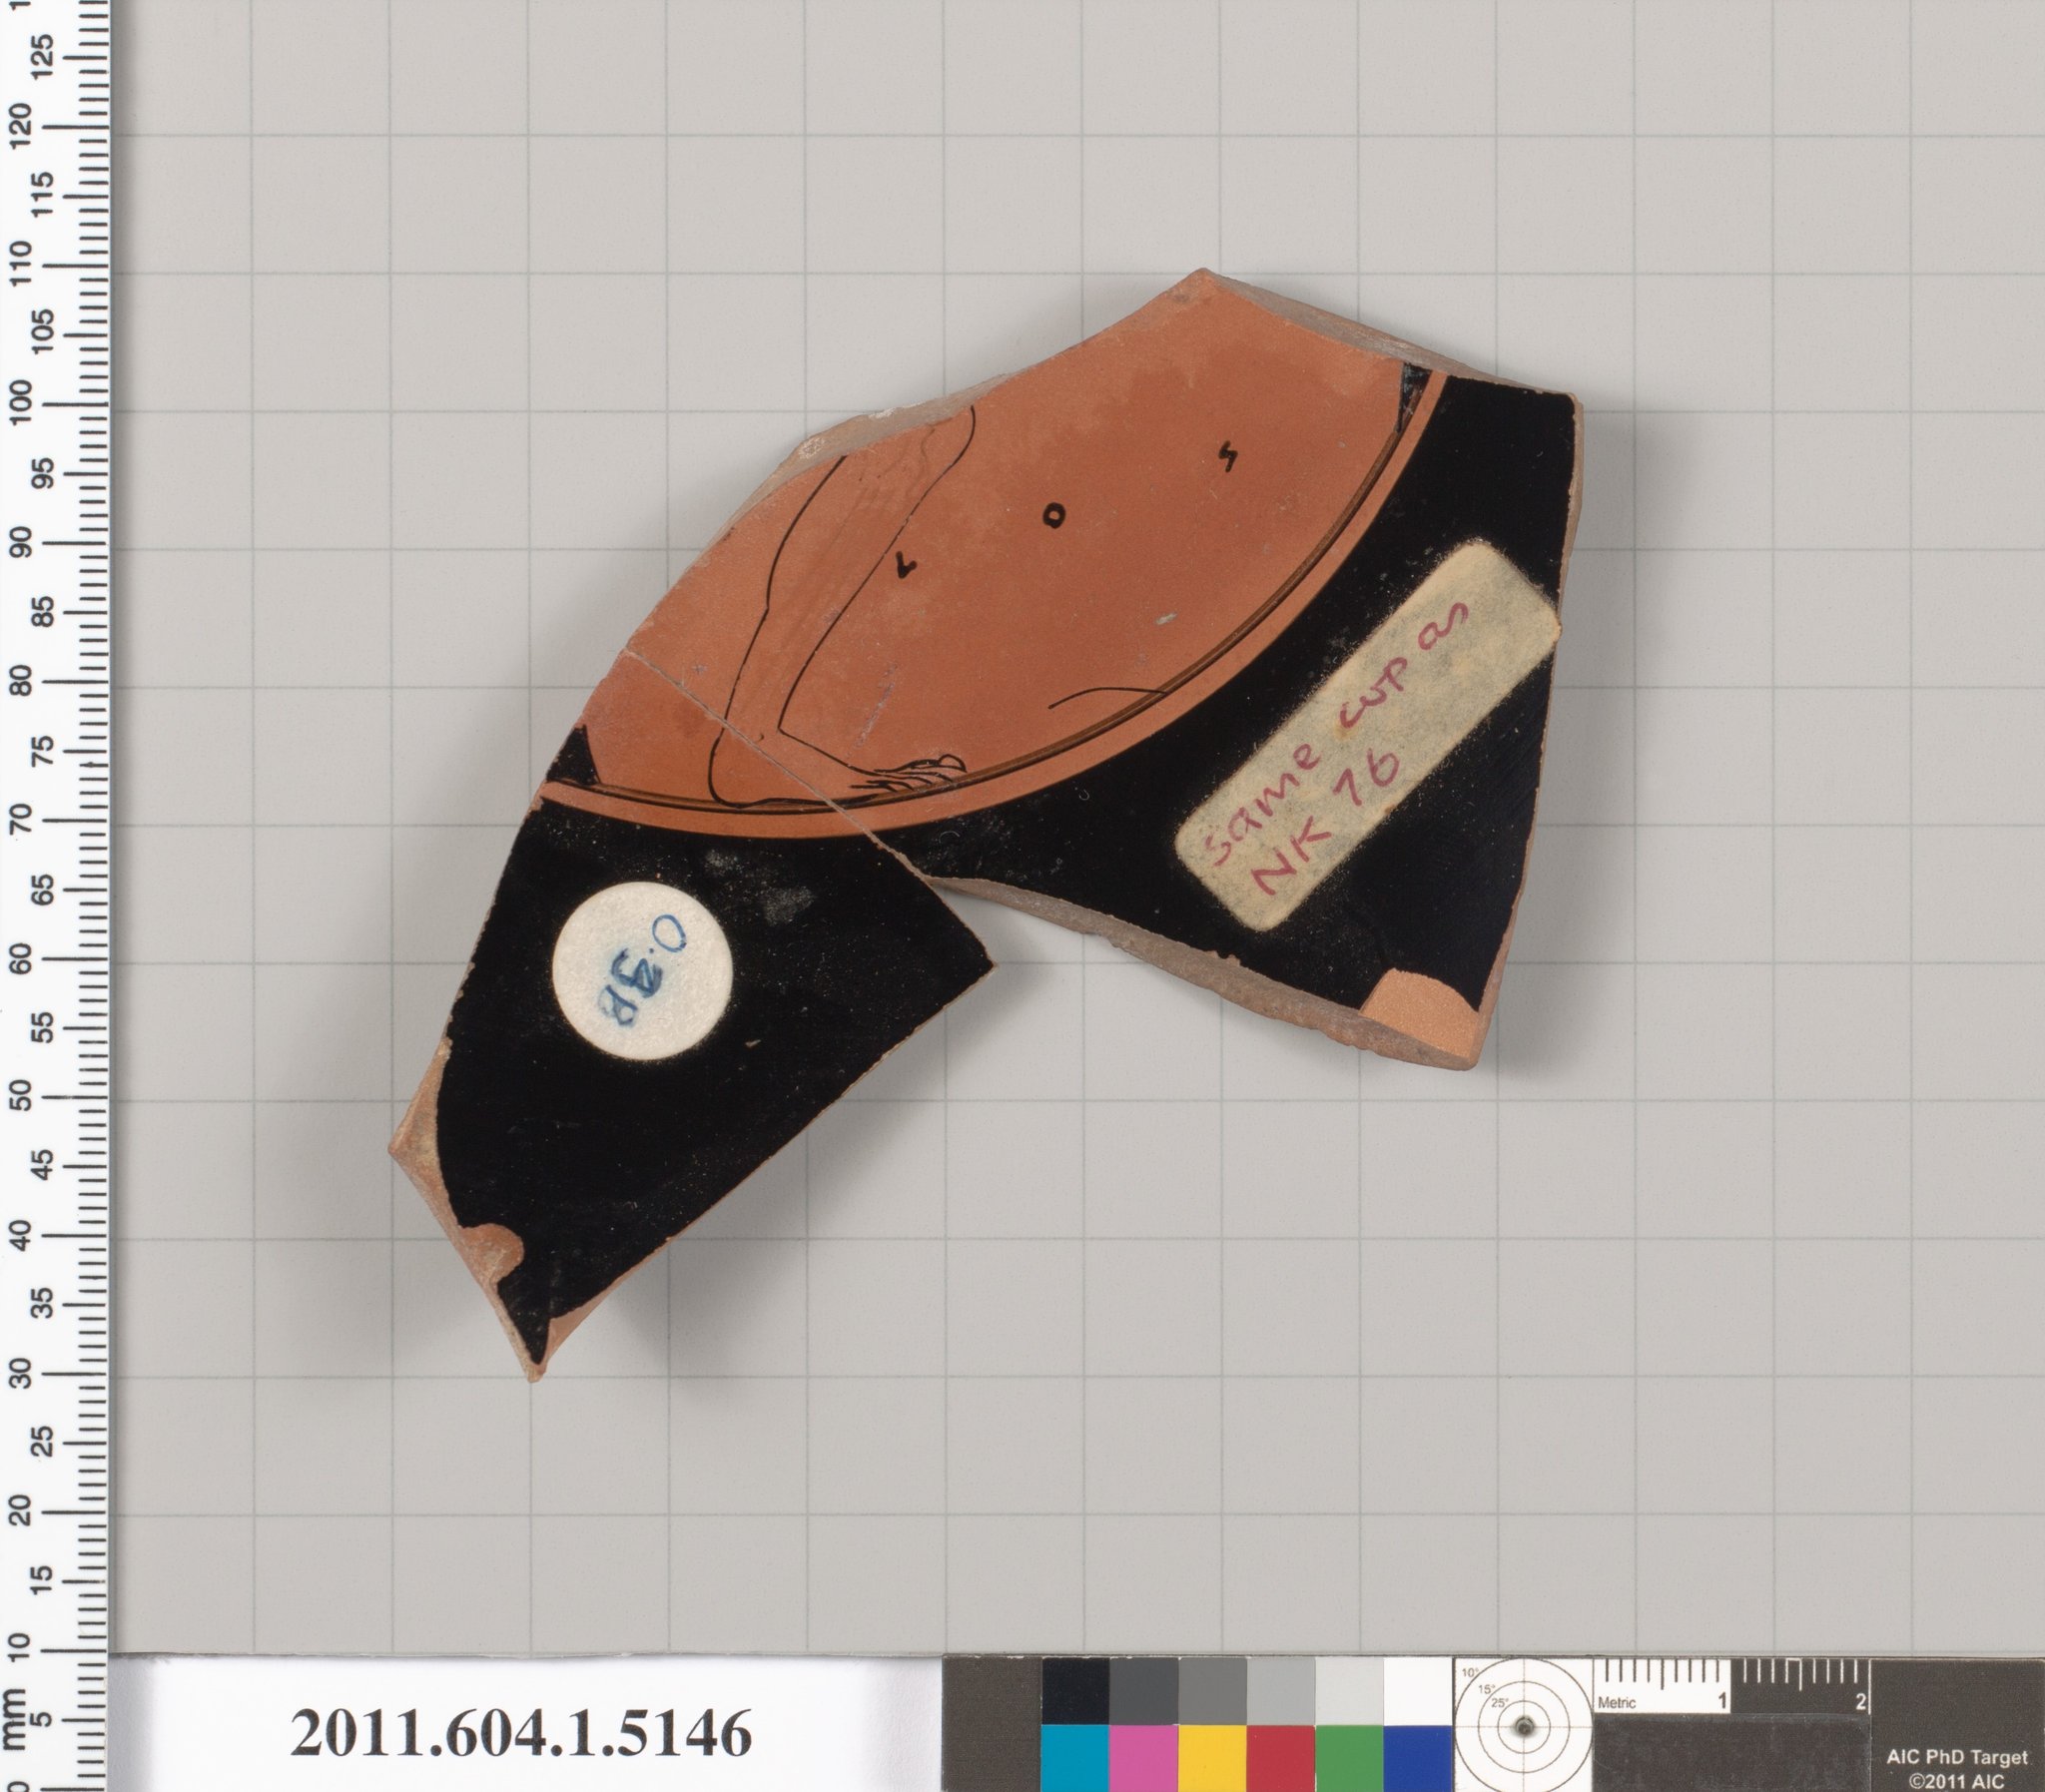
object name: kylix fragment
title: Terracotta fragment of a kylix (drinking cup)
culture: greek, attic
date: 500-480 BCE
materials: terracotta